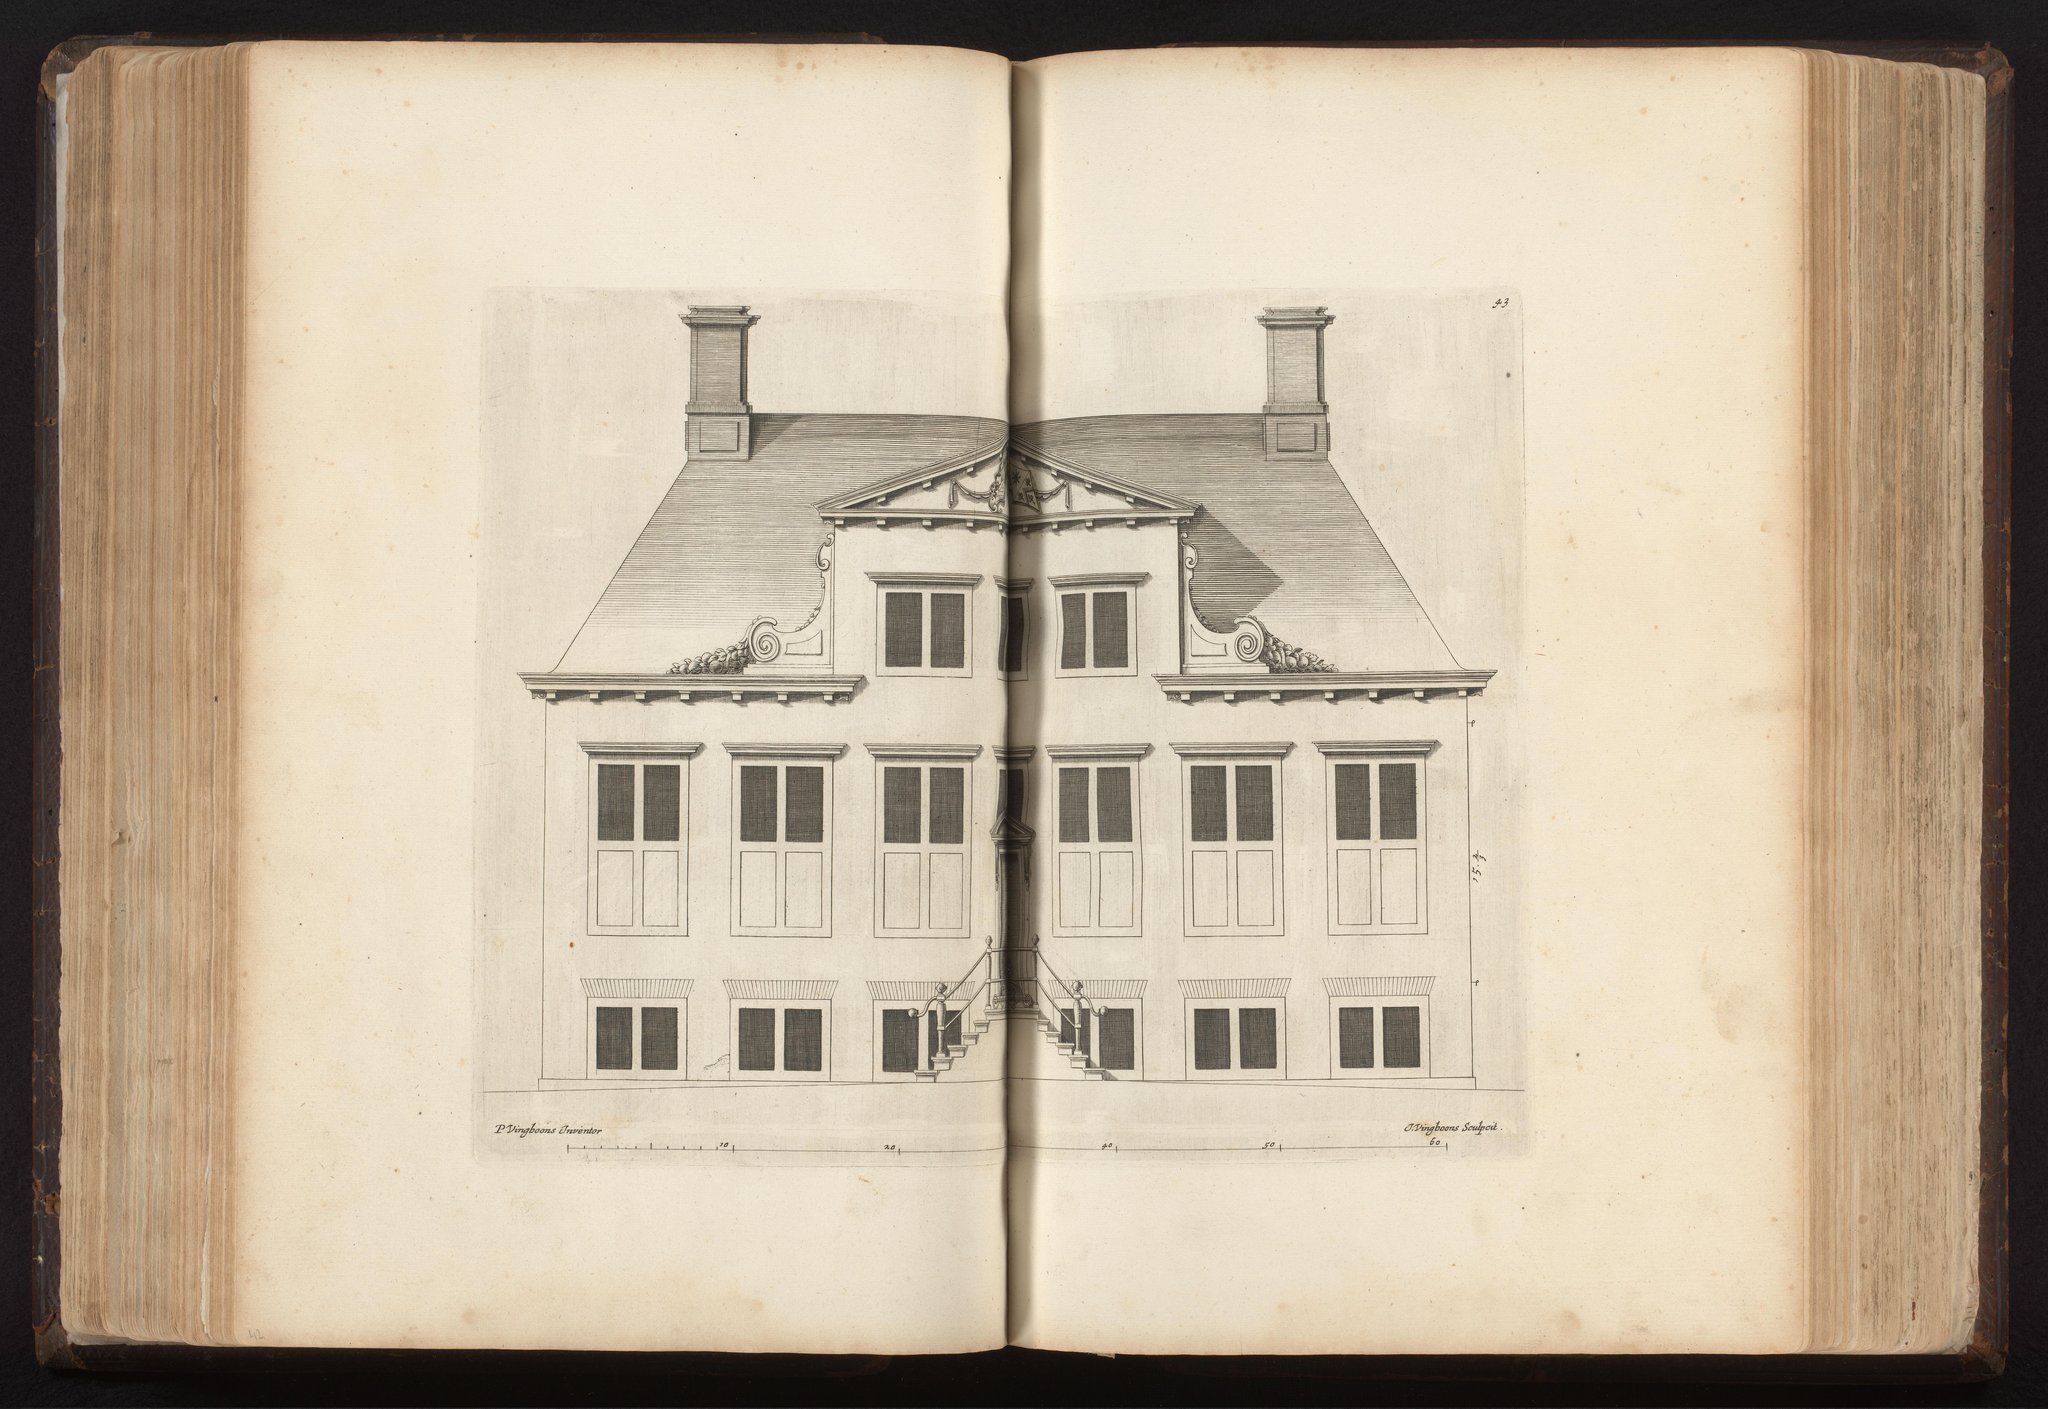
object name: book illustration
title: Gevel van het landhuis Groenhoven te Amstelveen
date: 1648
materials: paper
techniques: engraving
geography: amsterdam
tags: country-house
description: Prent uit: Afbeelsels der voornaemste gebouwen uyt alle die Philips Vingboons geordineert heeft. Amsterdam: Philips en Johannes Vinckboons en Johannes Willemszoon Blaeu, 1648.